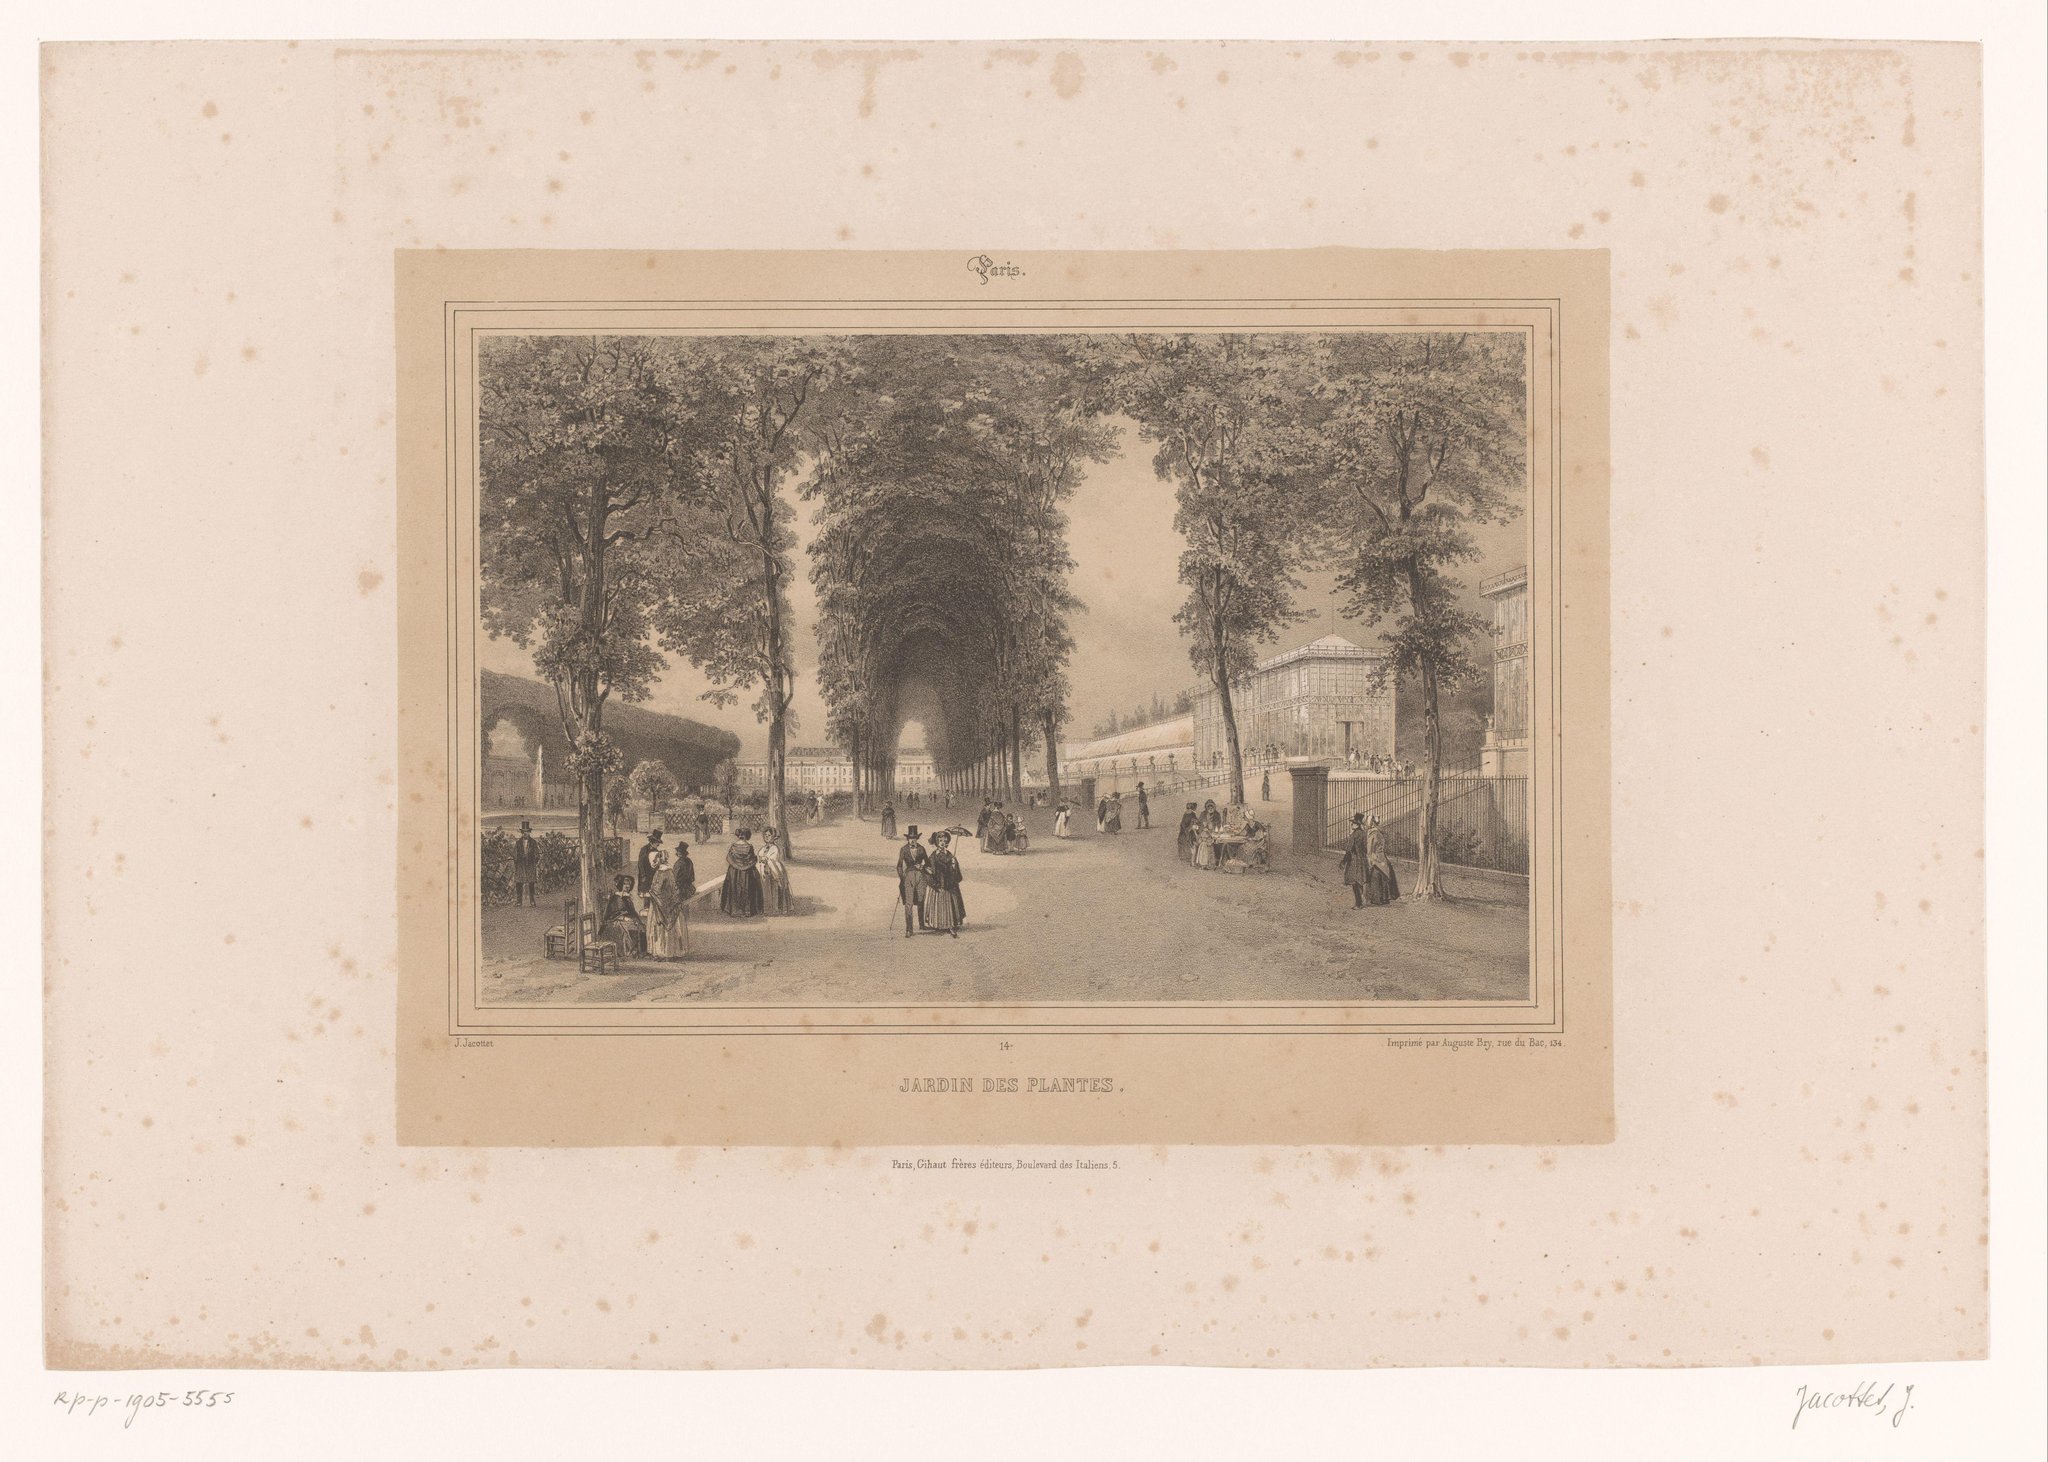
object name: print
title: Paris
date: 1838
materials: paper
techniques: tone lithography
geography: paris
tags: public gardens, park (+ city(-scape) with figures, staffage), botanic garden, 'hortus botanicus'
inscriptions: collector's mark: Lugt 2228a